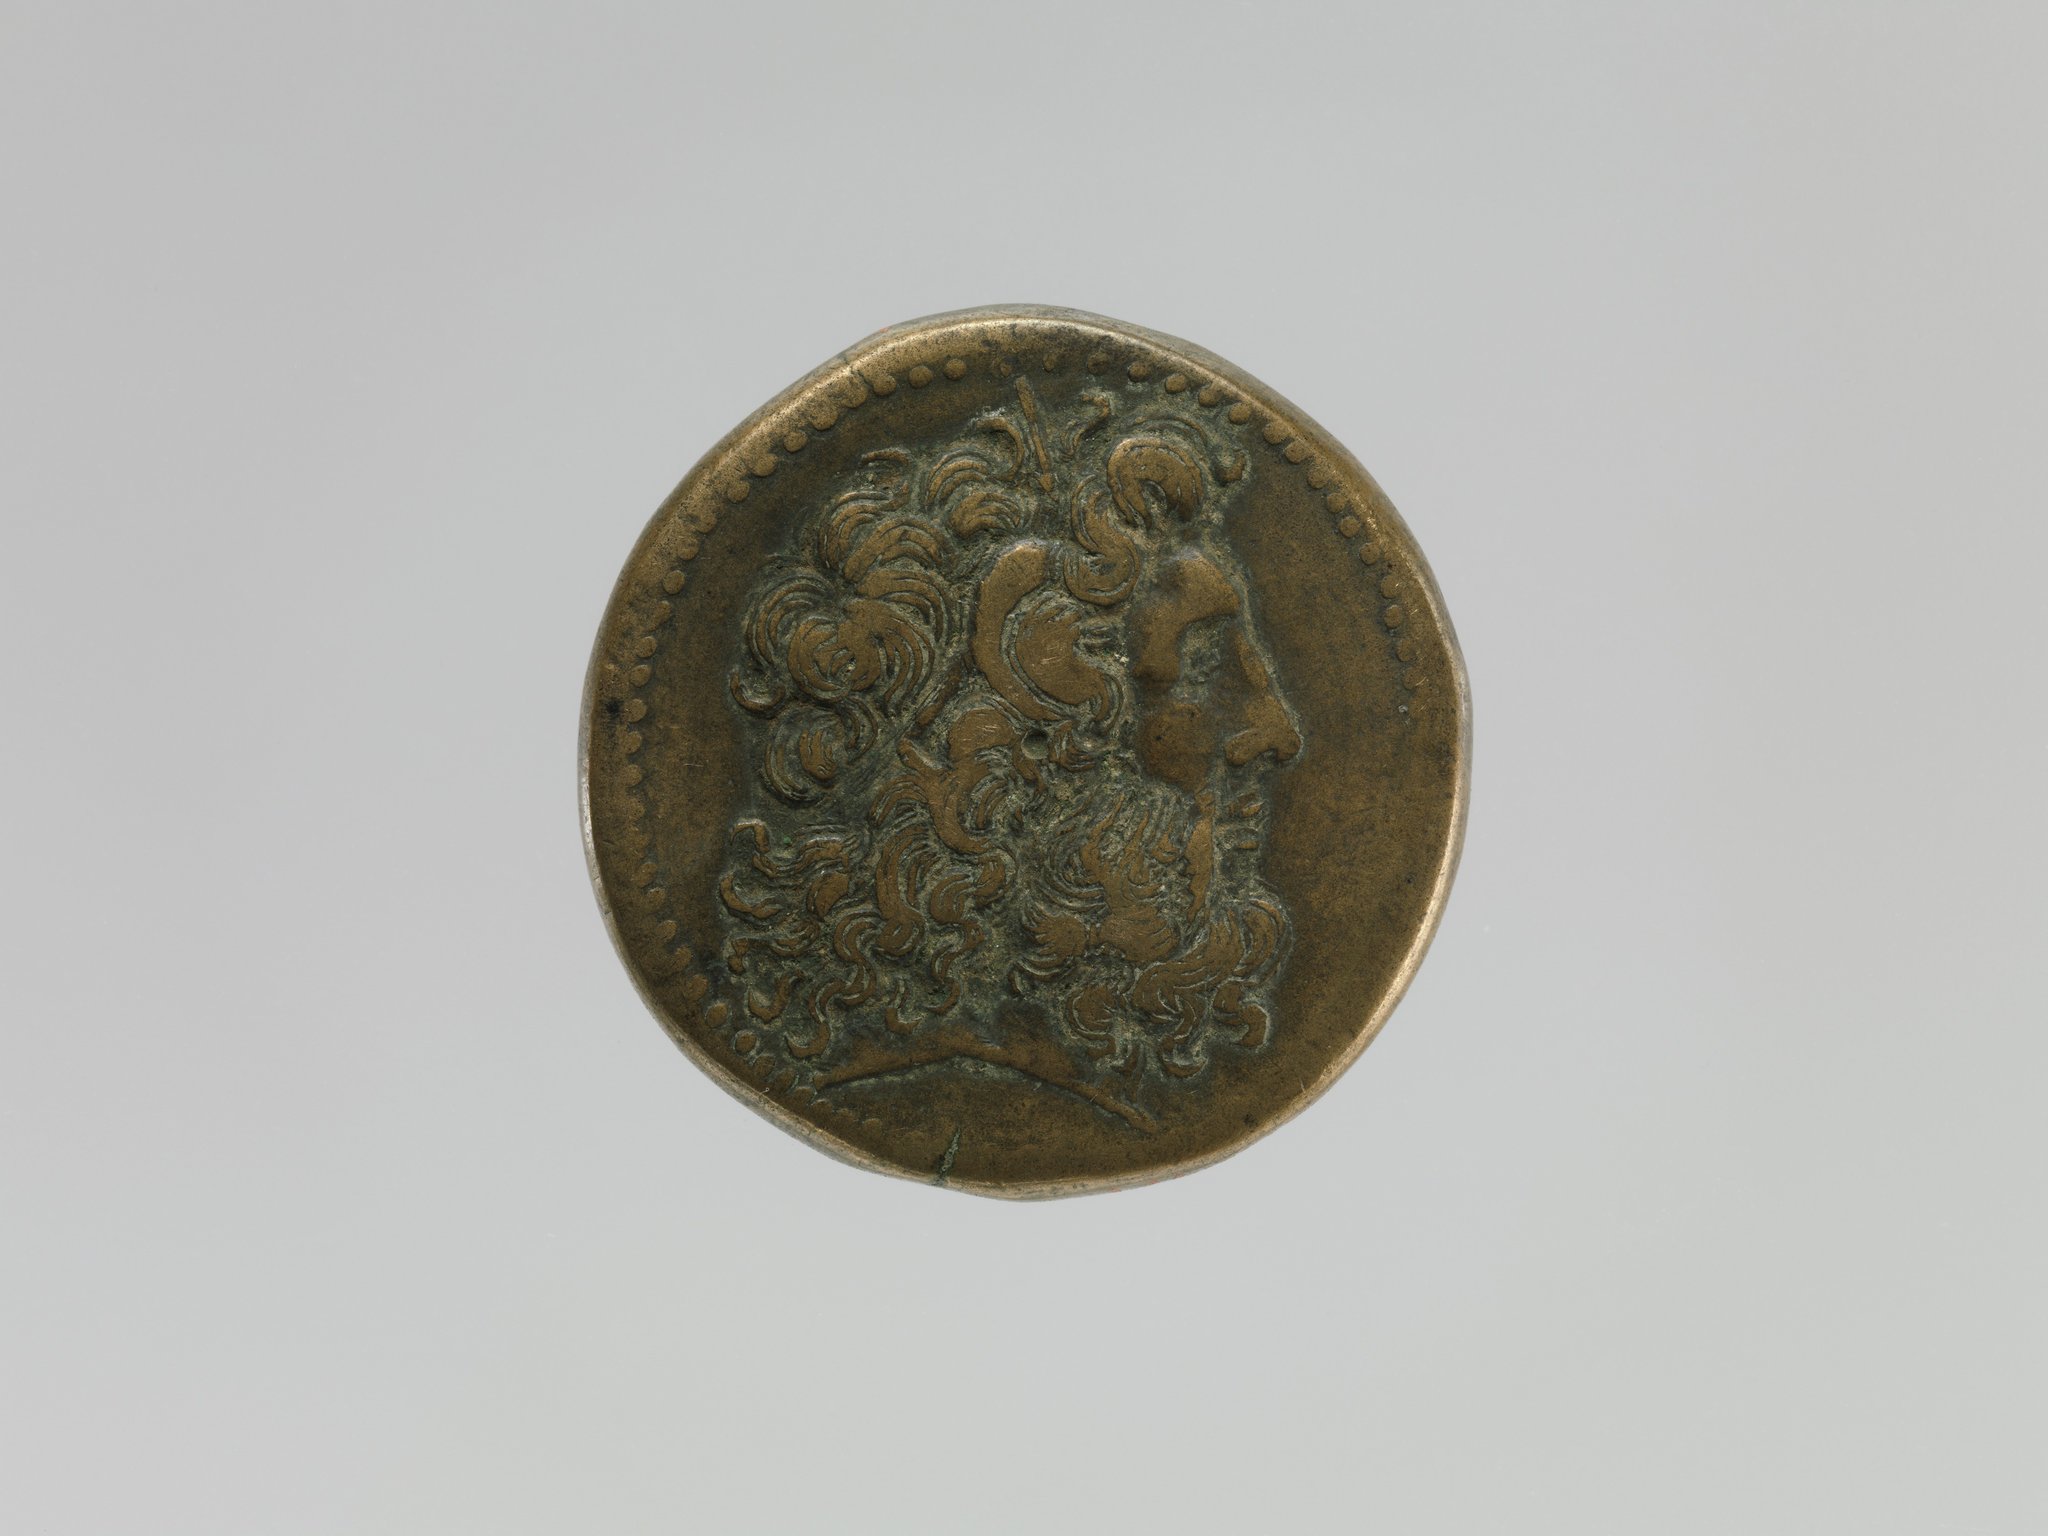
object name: coin, ptolemy iii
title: Coin of Ptolemy III from a Ptolemaic hoard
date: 246-222 BCE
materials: bronze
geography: egypt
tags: men